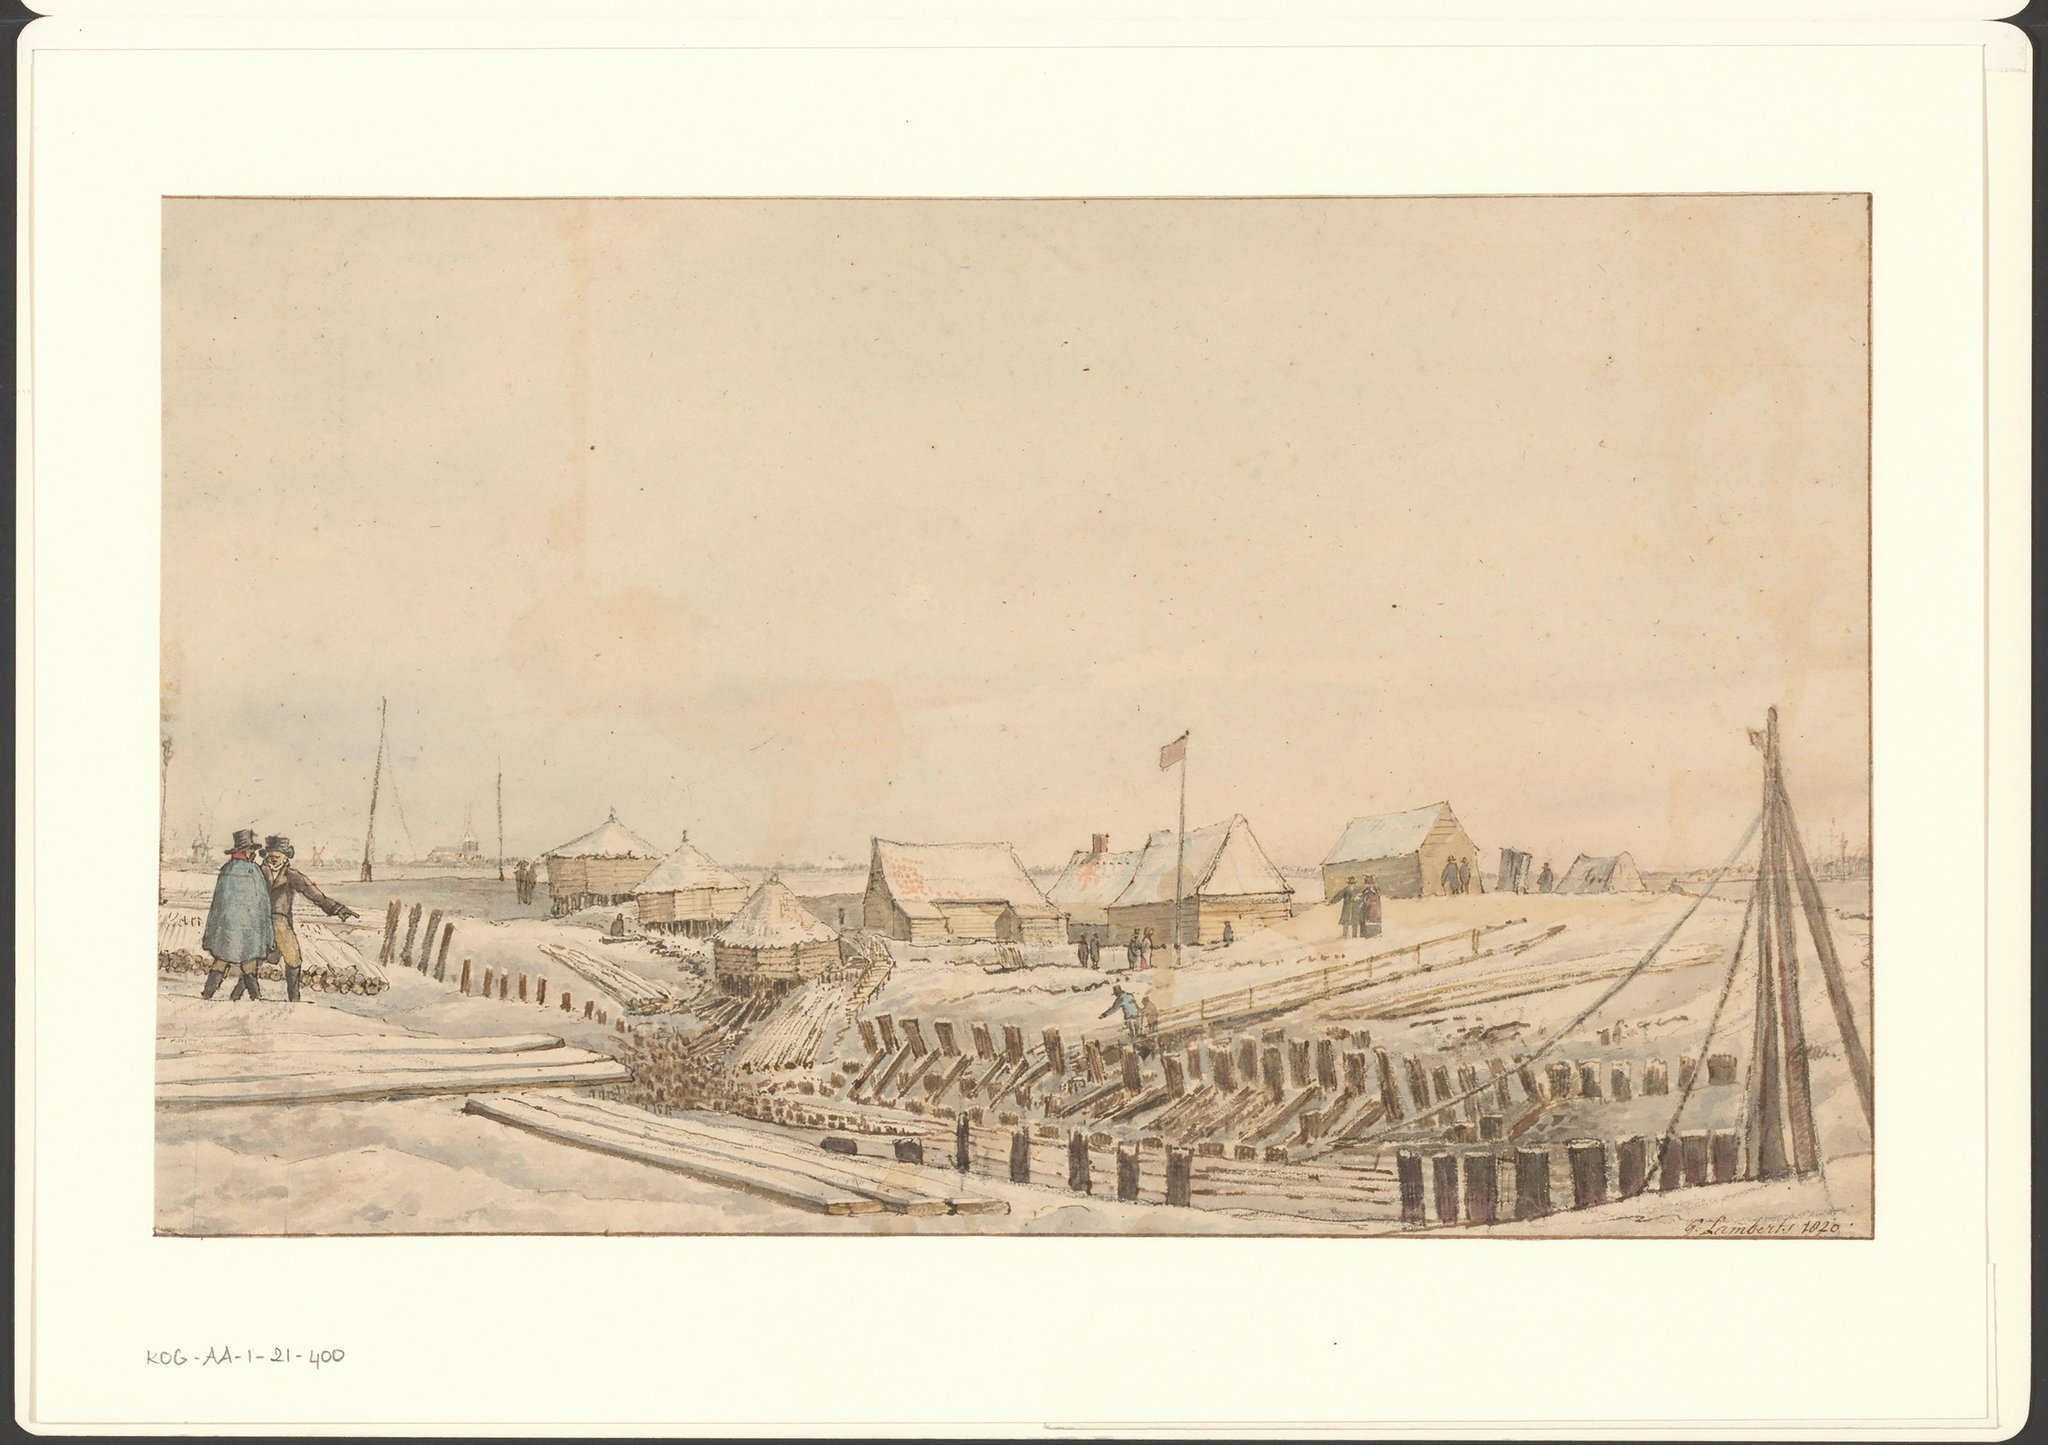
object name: drawing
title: Gezicht bij de Willemsluis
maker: gerrit lamberts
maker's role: bookseller, draughtsman, print maker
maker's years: 1776-1850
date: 1820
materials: chalk, ink, paper, watercolor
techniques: brush, pen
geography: amsterdam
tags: sluice, weir, city-view in general; 'veduta', hut, cabin, lodge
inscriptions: collector's mark: ‘21’ Lugt 1641b, signature and date: ‘G. Lamberts 1820.’, inscription: ‘neg 13x18: 719 (...) Gerrit Lamberts. 1820’